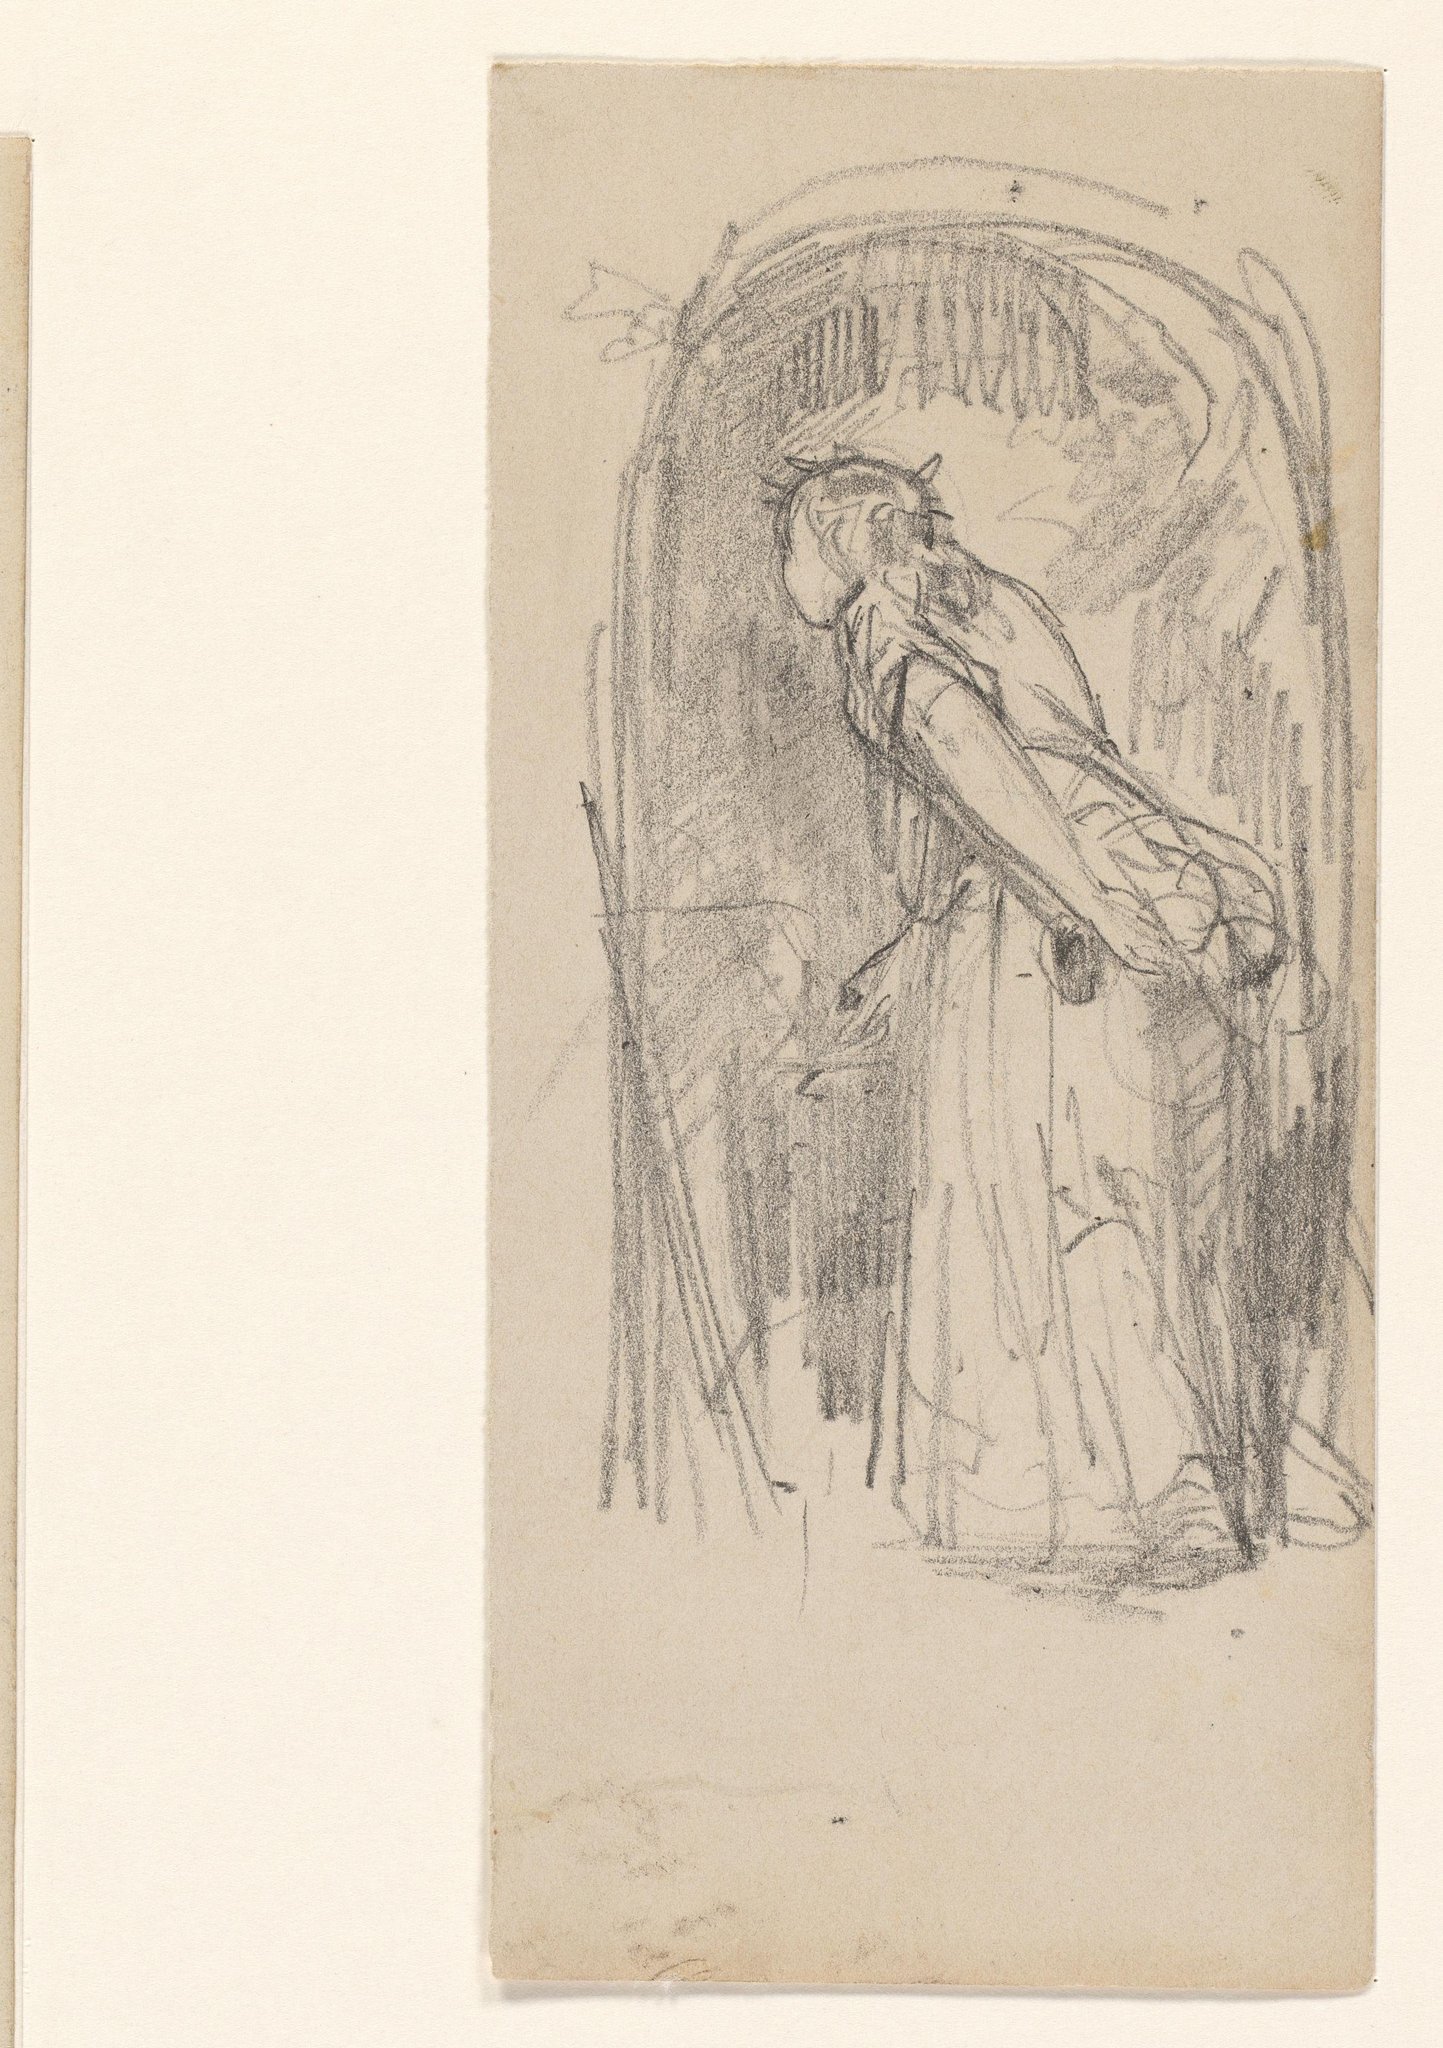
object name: drawing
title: Meisje, dat in een deuropening staat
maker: august allebé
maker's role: draughtsman, print maker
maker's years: 1838-1927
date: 1848-1927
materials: chalk, paper